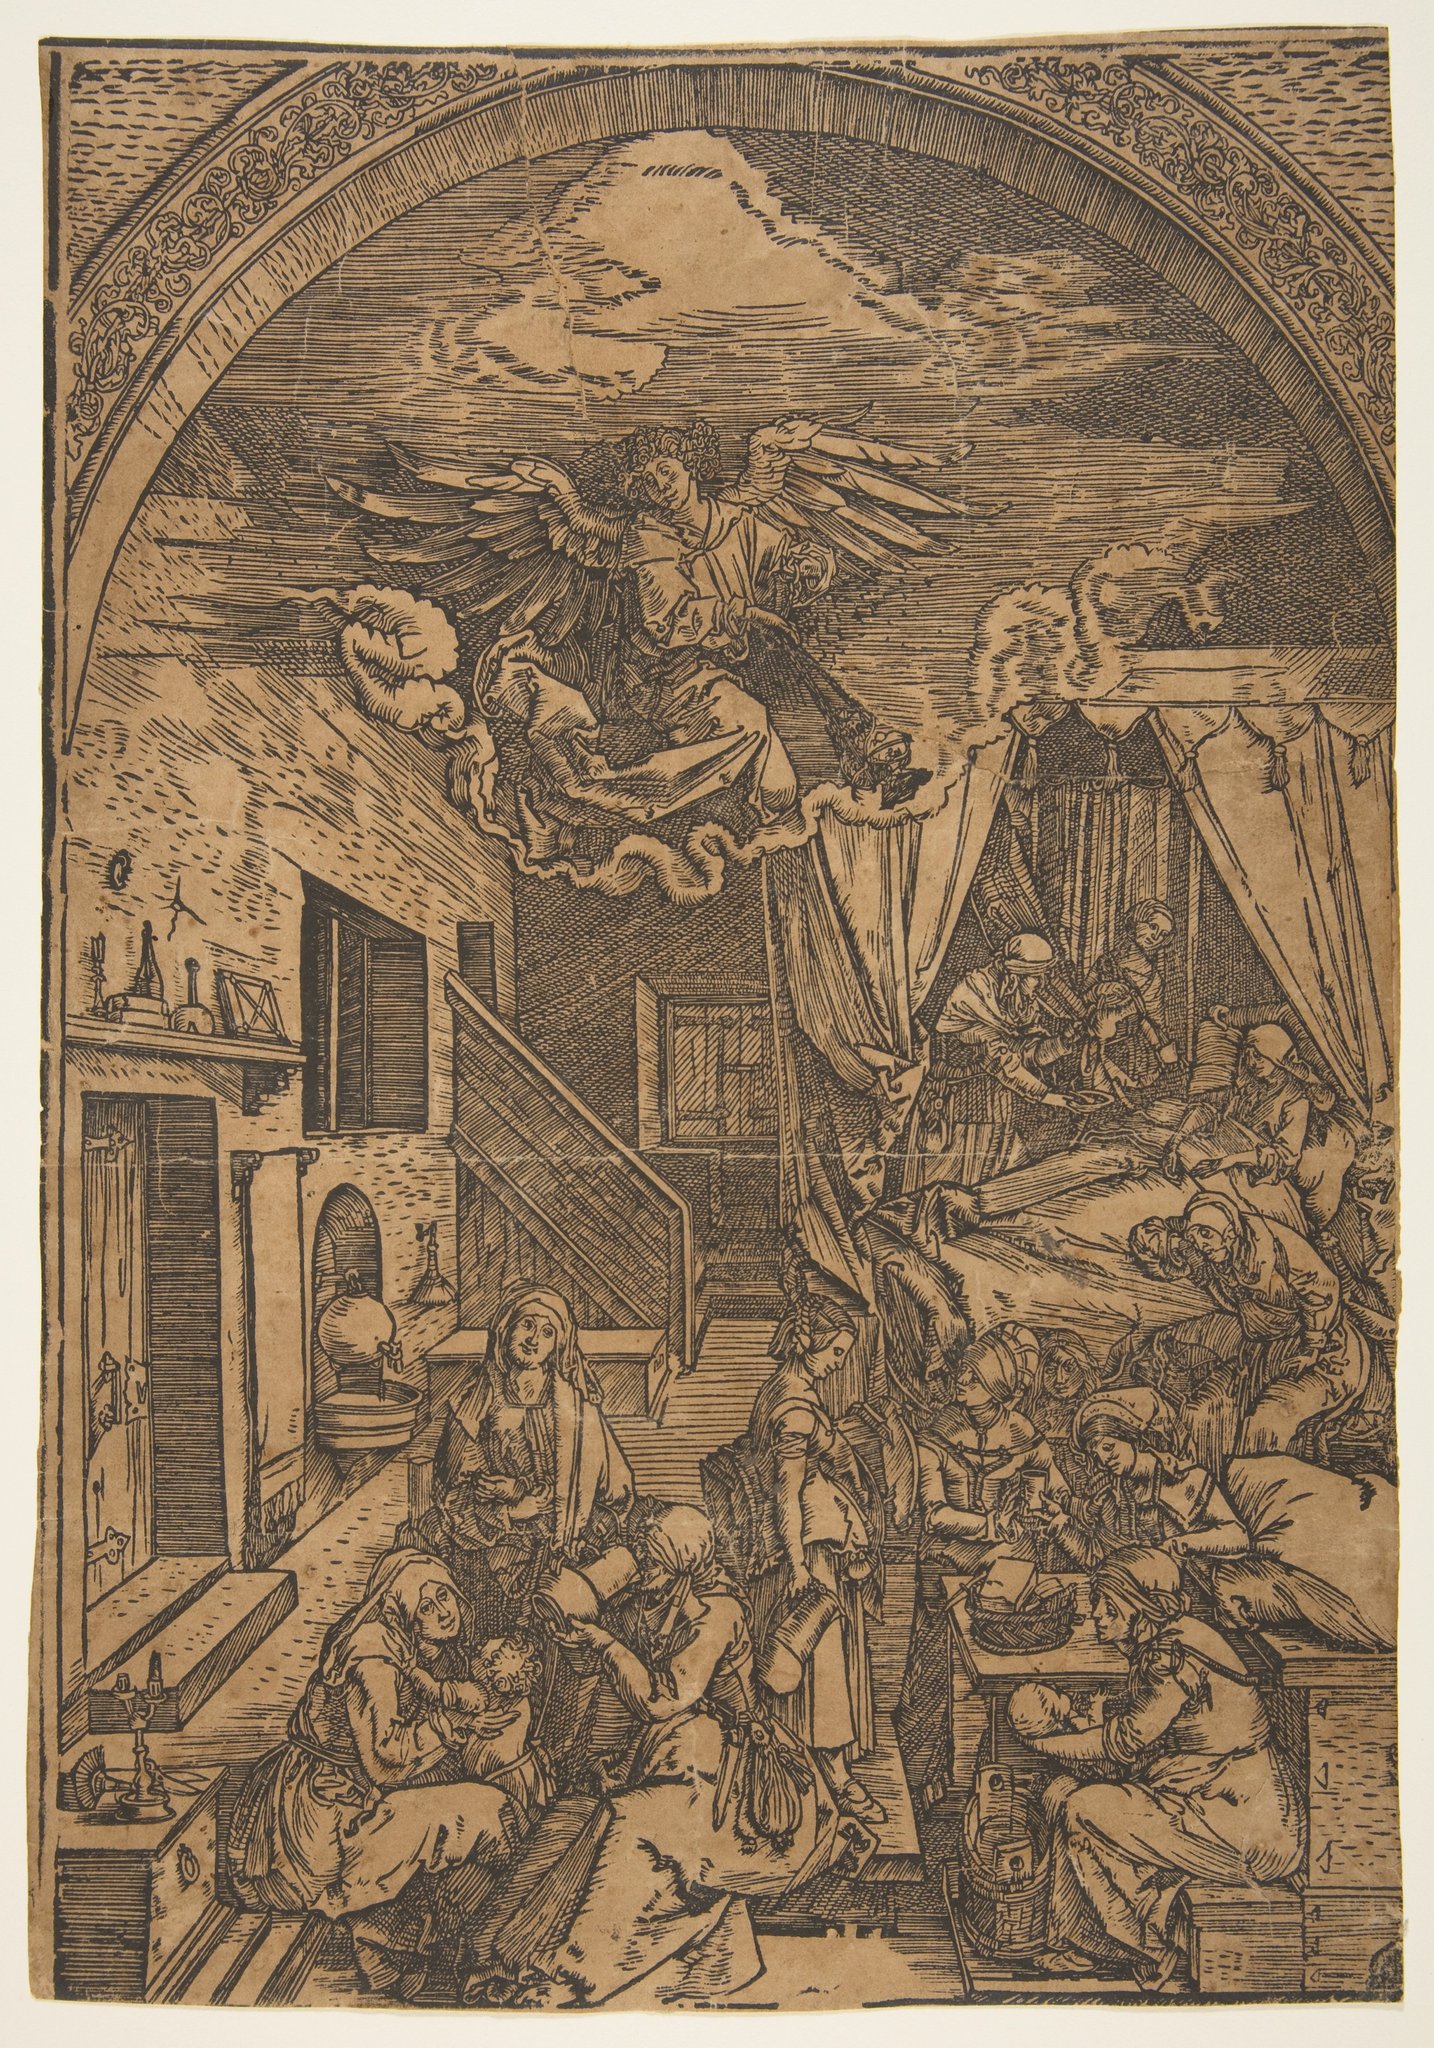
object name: print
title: The Birth of the Virgin, from "The Life of the Virgin" (copy)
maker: albrecht dürer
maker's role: artist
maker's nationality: german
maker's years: 1471-1528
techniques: woodcut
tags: men,women,angels,virgin mary,birth